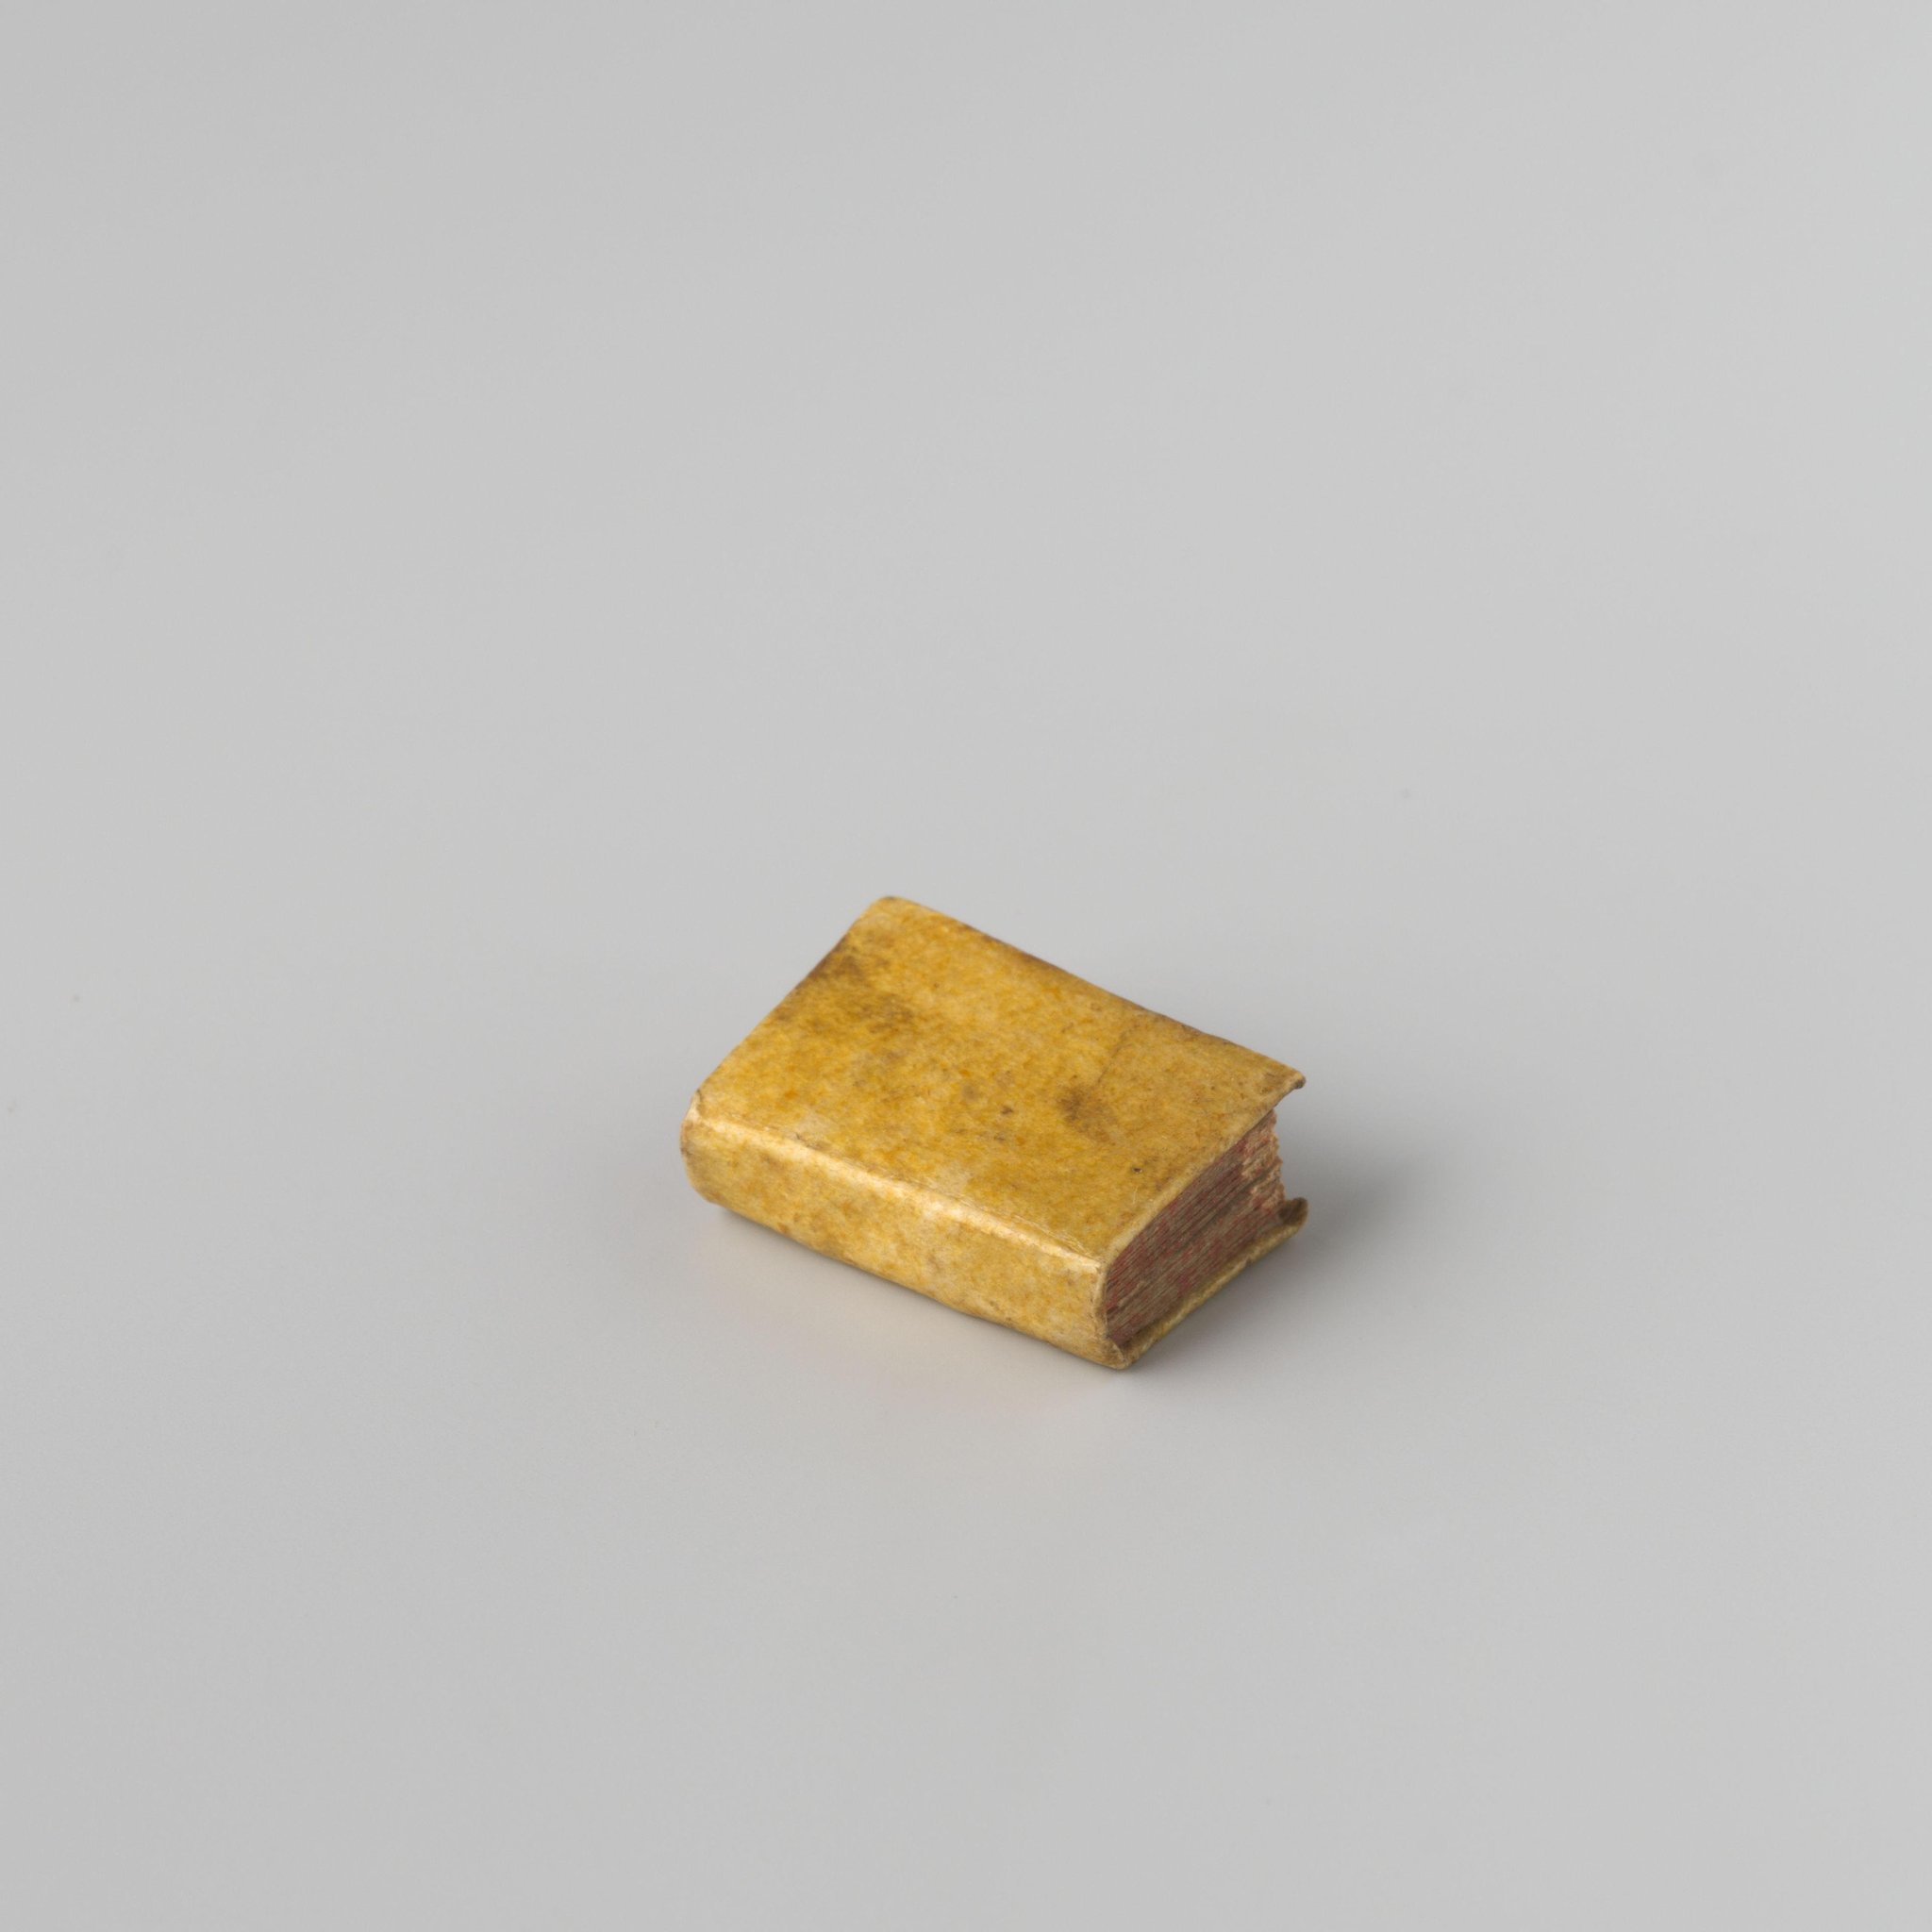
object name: miniature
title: Boek met figuren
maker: Anonymous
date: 1690-1710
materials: paper, parchment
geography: amsterdam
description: Boek met figuren. Ingebonden in geel gekleurd perkament.